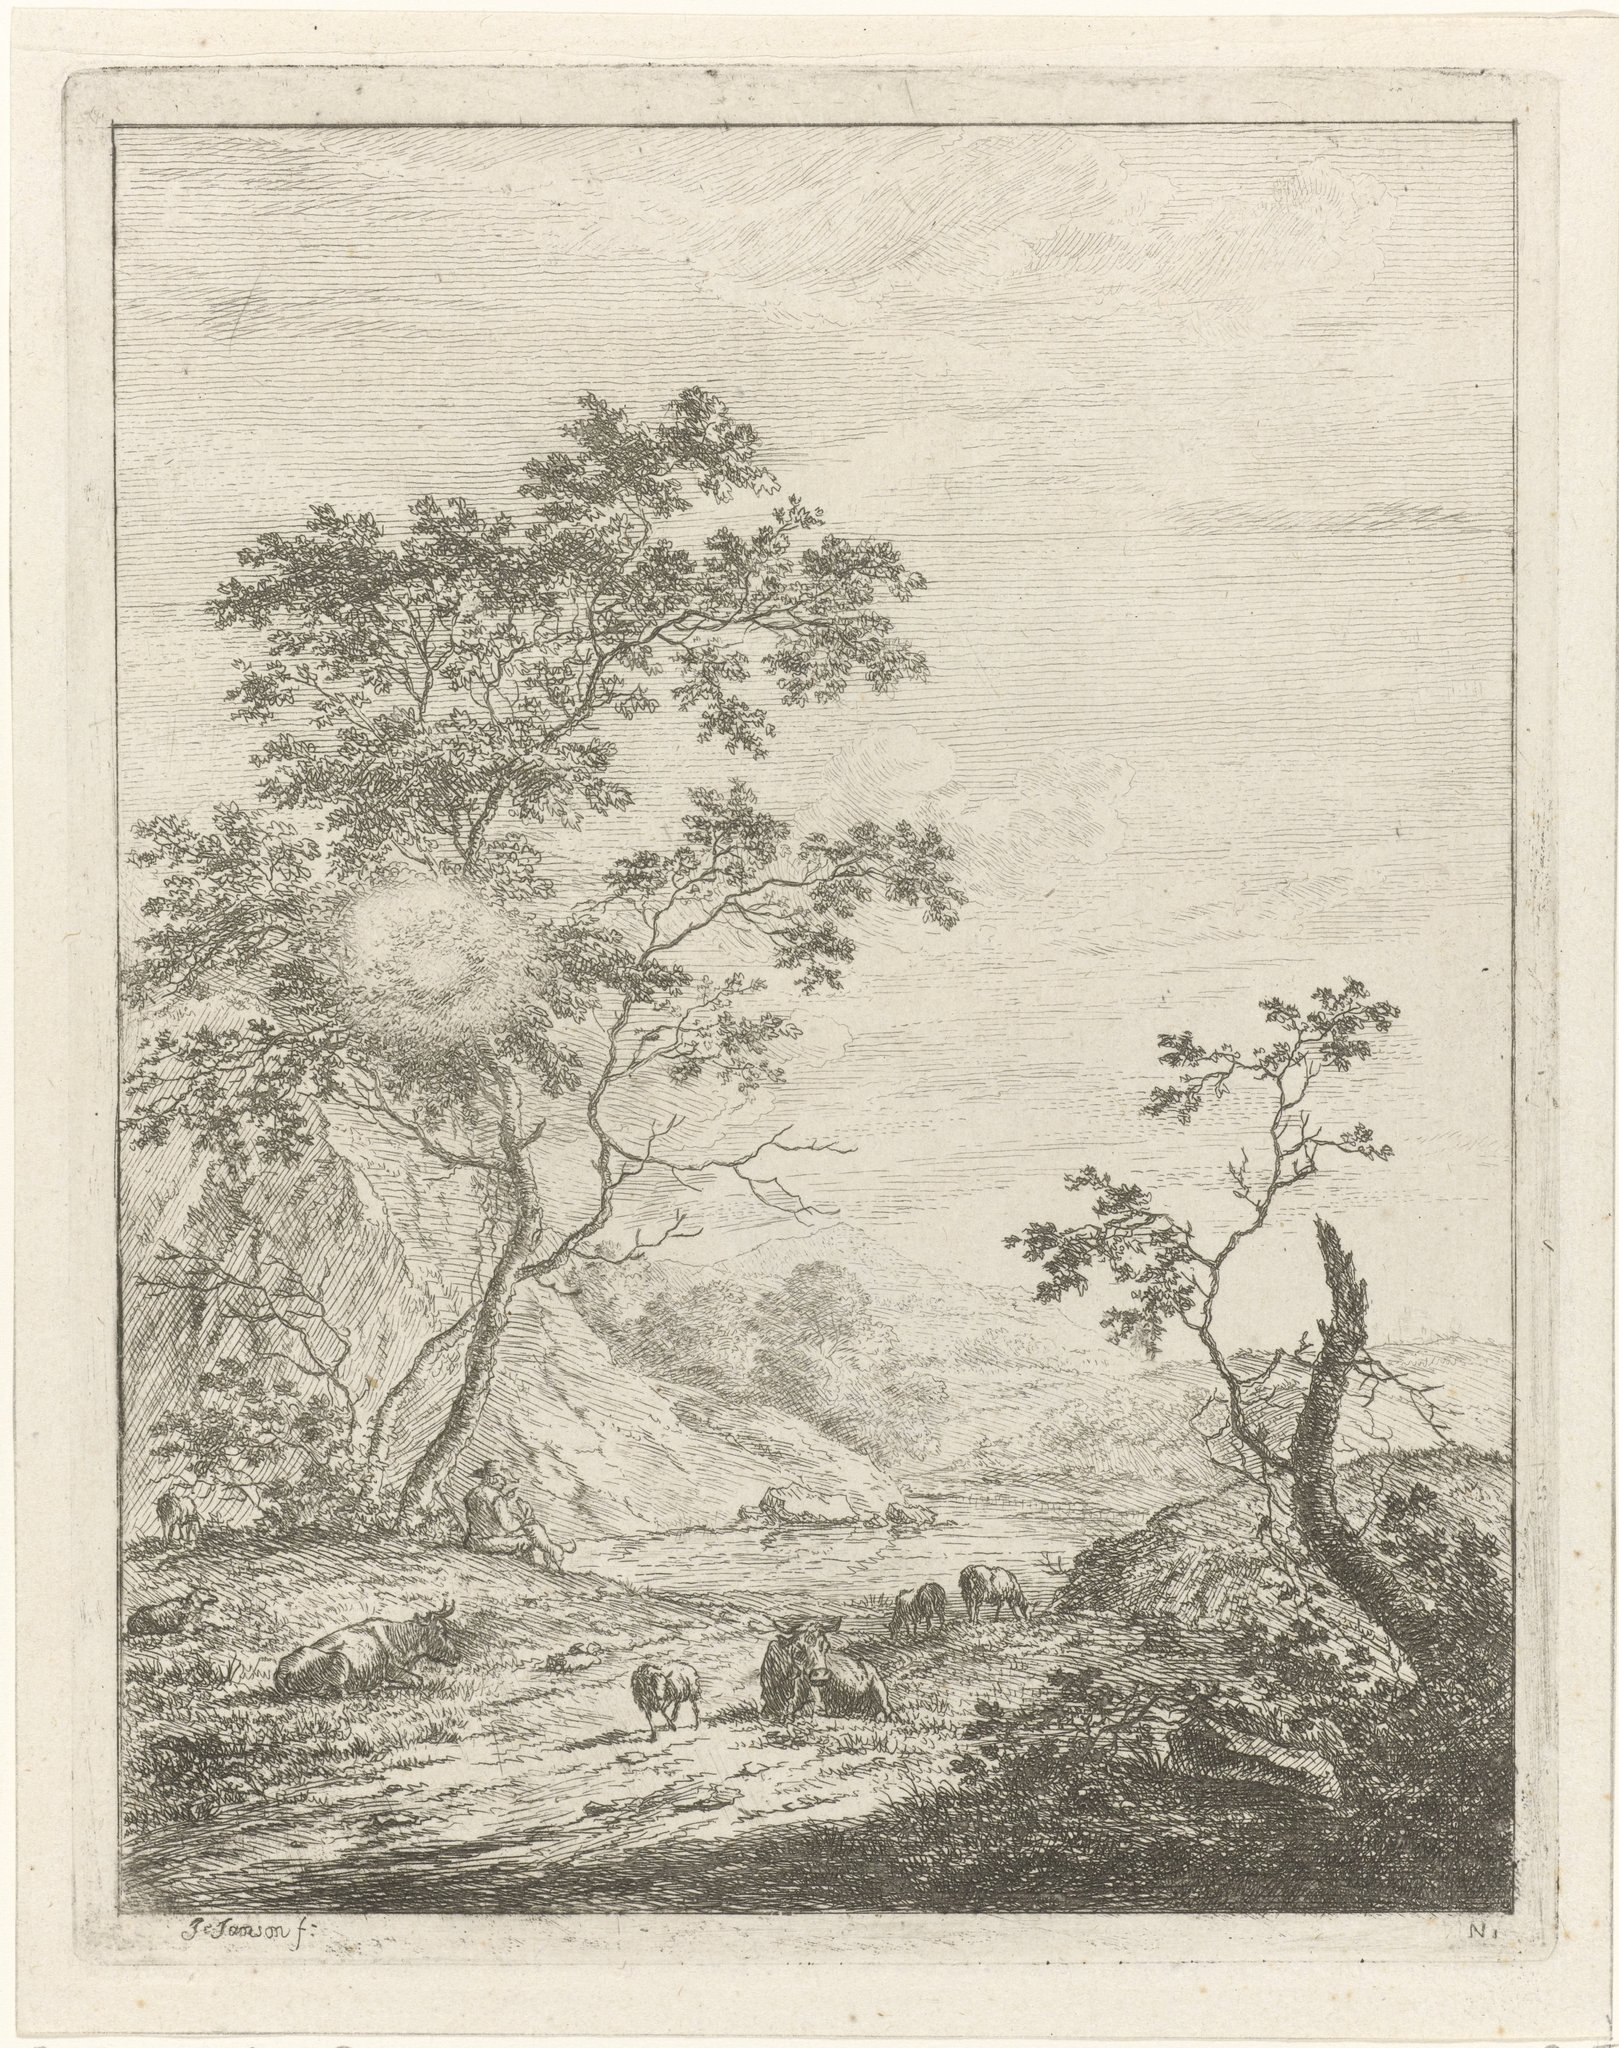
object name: print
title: Bergachtig landschap met herder en vee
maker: johannes janson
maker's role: draughtsman, painter, print maker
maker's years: 1729-1784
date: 1761-1784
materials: paper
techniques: etching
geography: leiden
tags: cow, sheep, dog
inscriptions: collector's mark: Lugt 2228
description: Een bergachtig landschap met koeien en schapen. Zittend aan het water onder een boom, een herder met zijn hond. Prent uit een serie met landschappen met herders en vee.